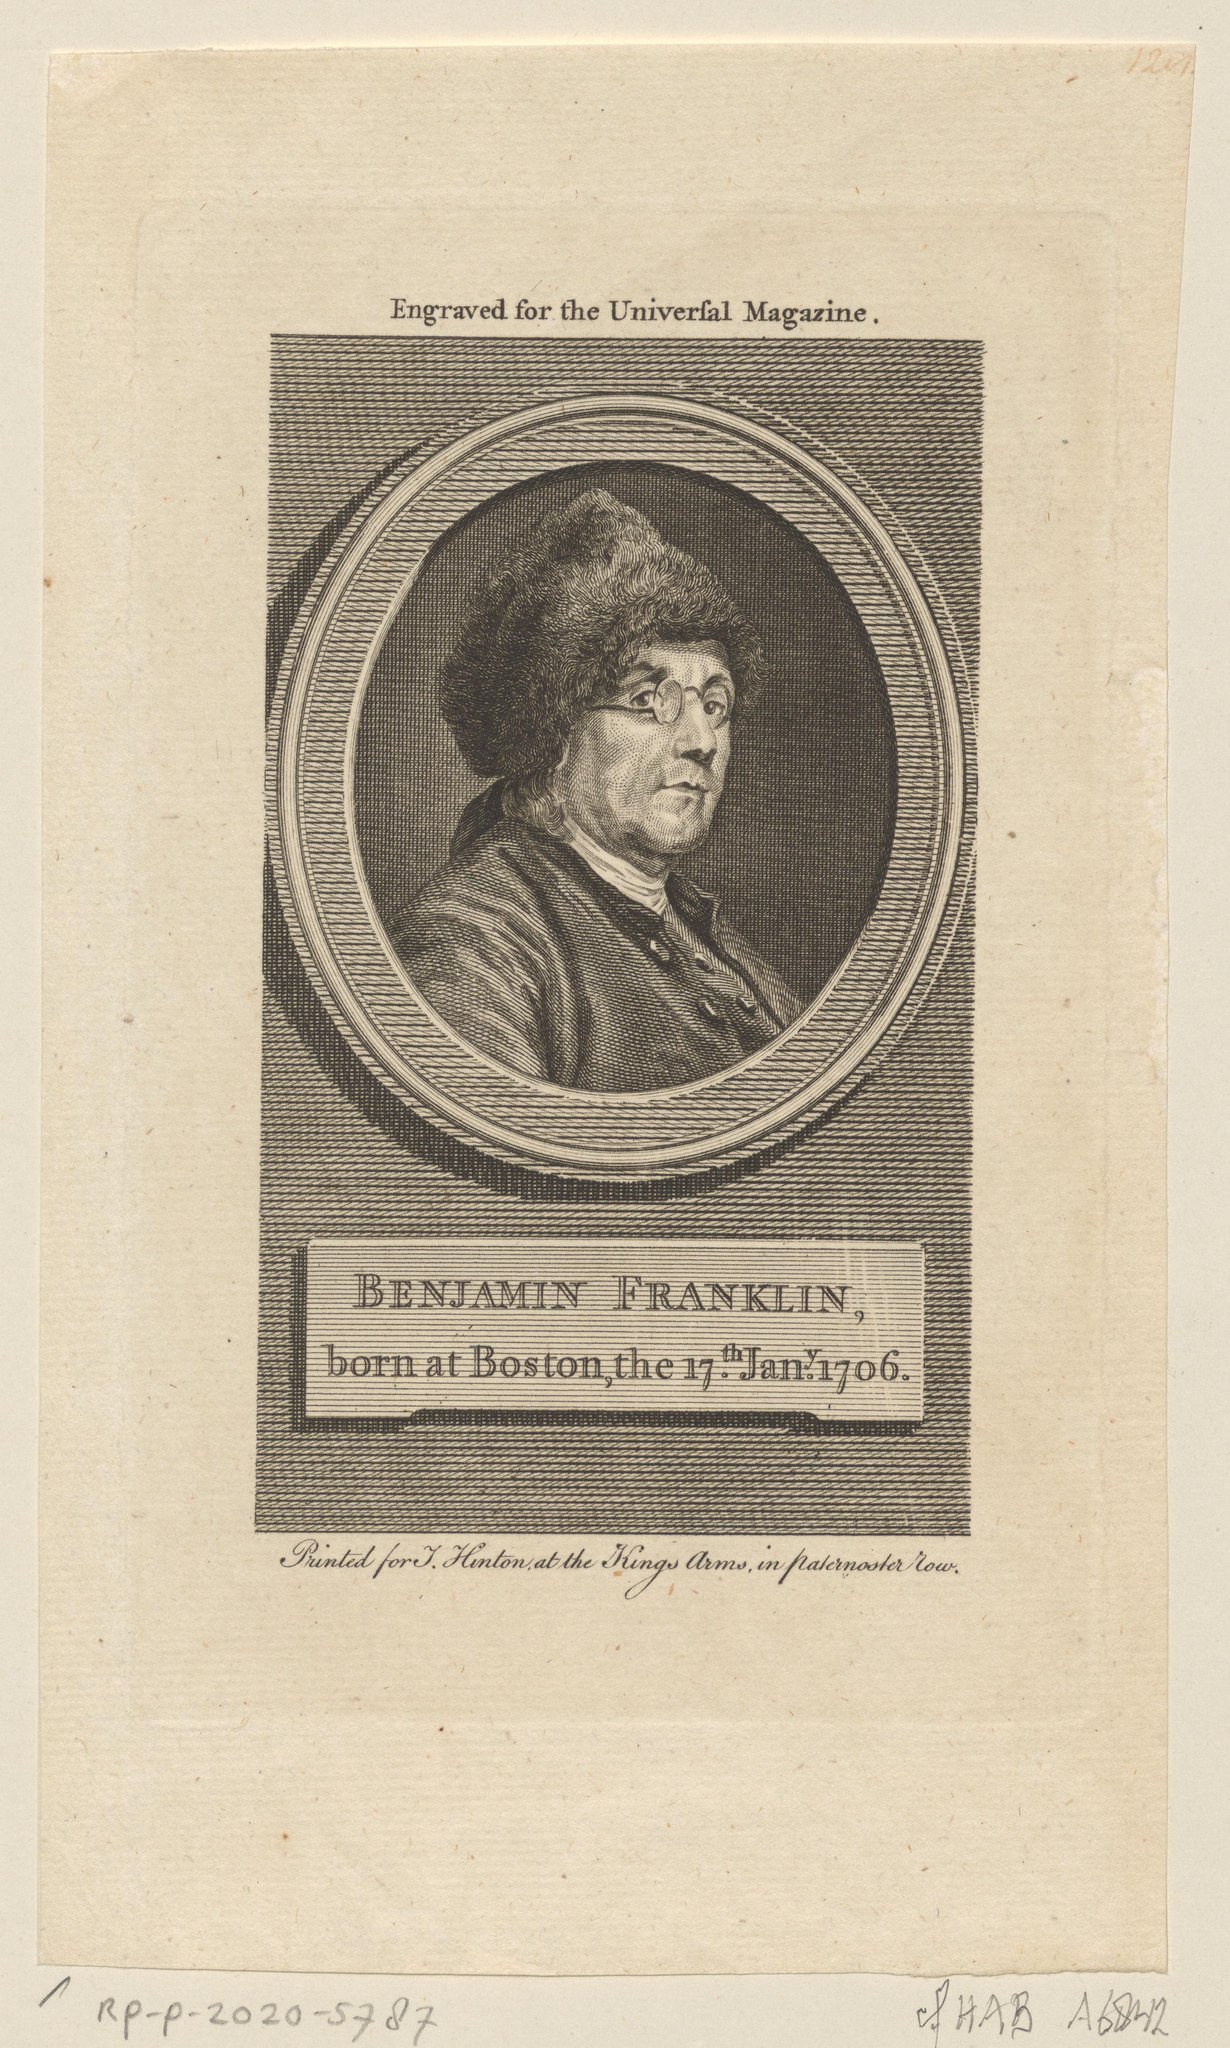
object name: print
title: Portret van Benjamin Franklin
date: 1776-1781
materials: paper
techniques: etching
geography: london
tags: physicist, historical persons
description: Prent komt uit een editie van The Universal Magazine of Knowledge and Pleasure, mogelijk uit 1777.